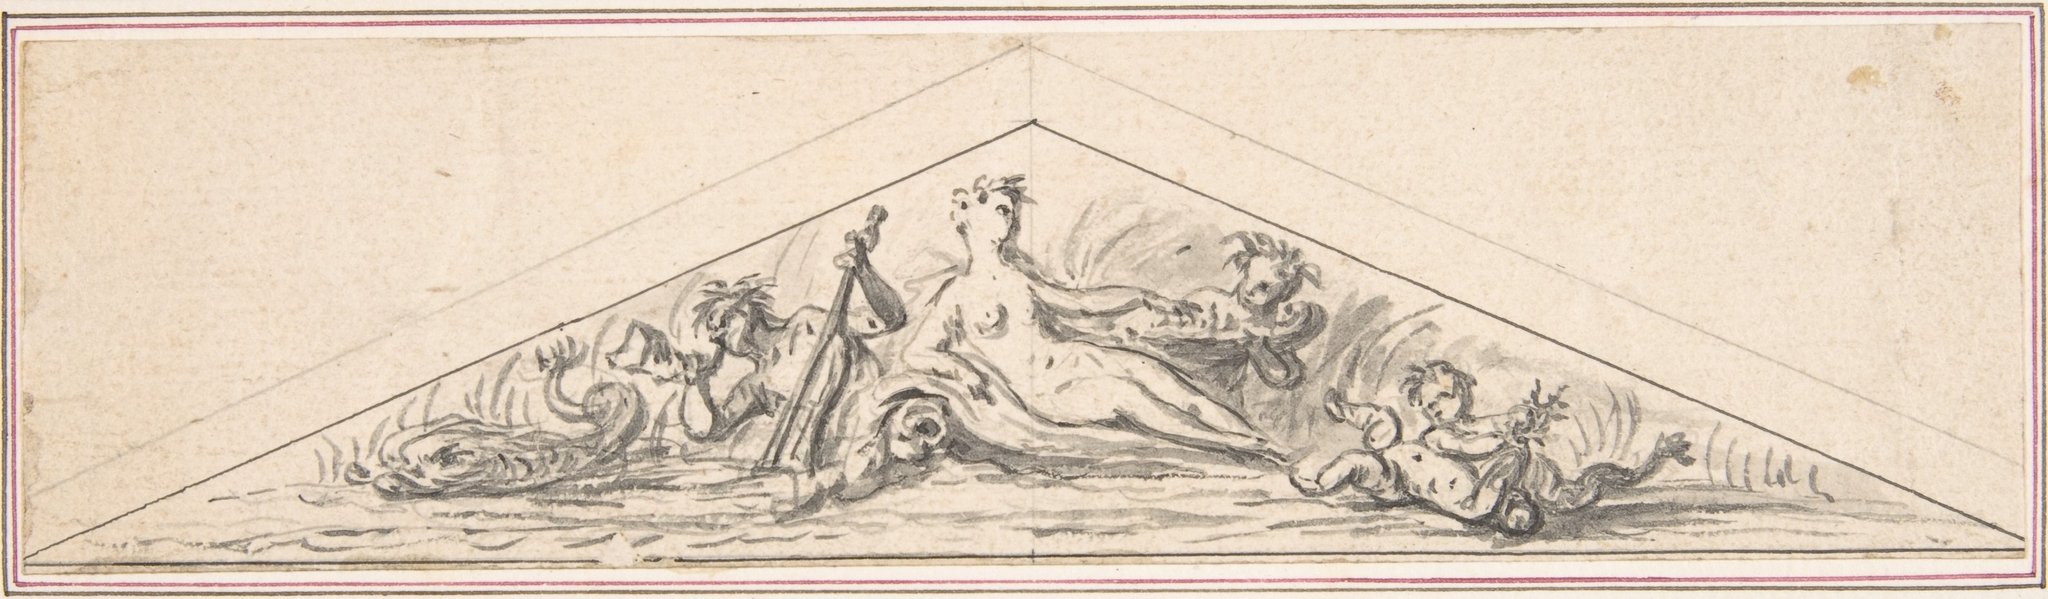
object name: drawing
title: Design for a Box-Front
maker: hubert françois gravelot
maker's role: artist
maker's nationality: french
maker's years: 1699-1773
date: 1701-1800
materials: graphite, ink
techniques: brush, pen, drawing, wash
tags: female nudes,serpents